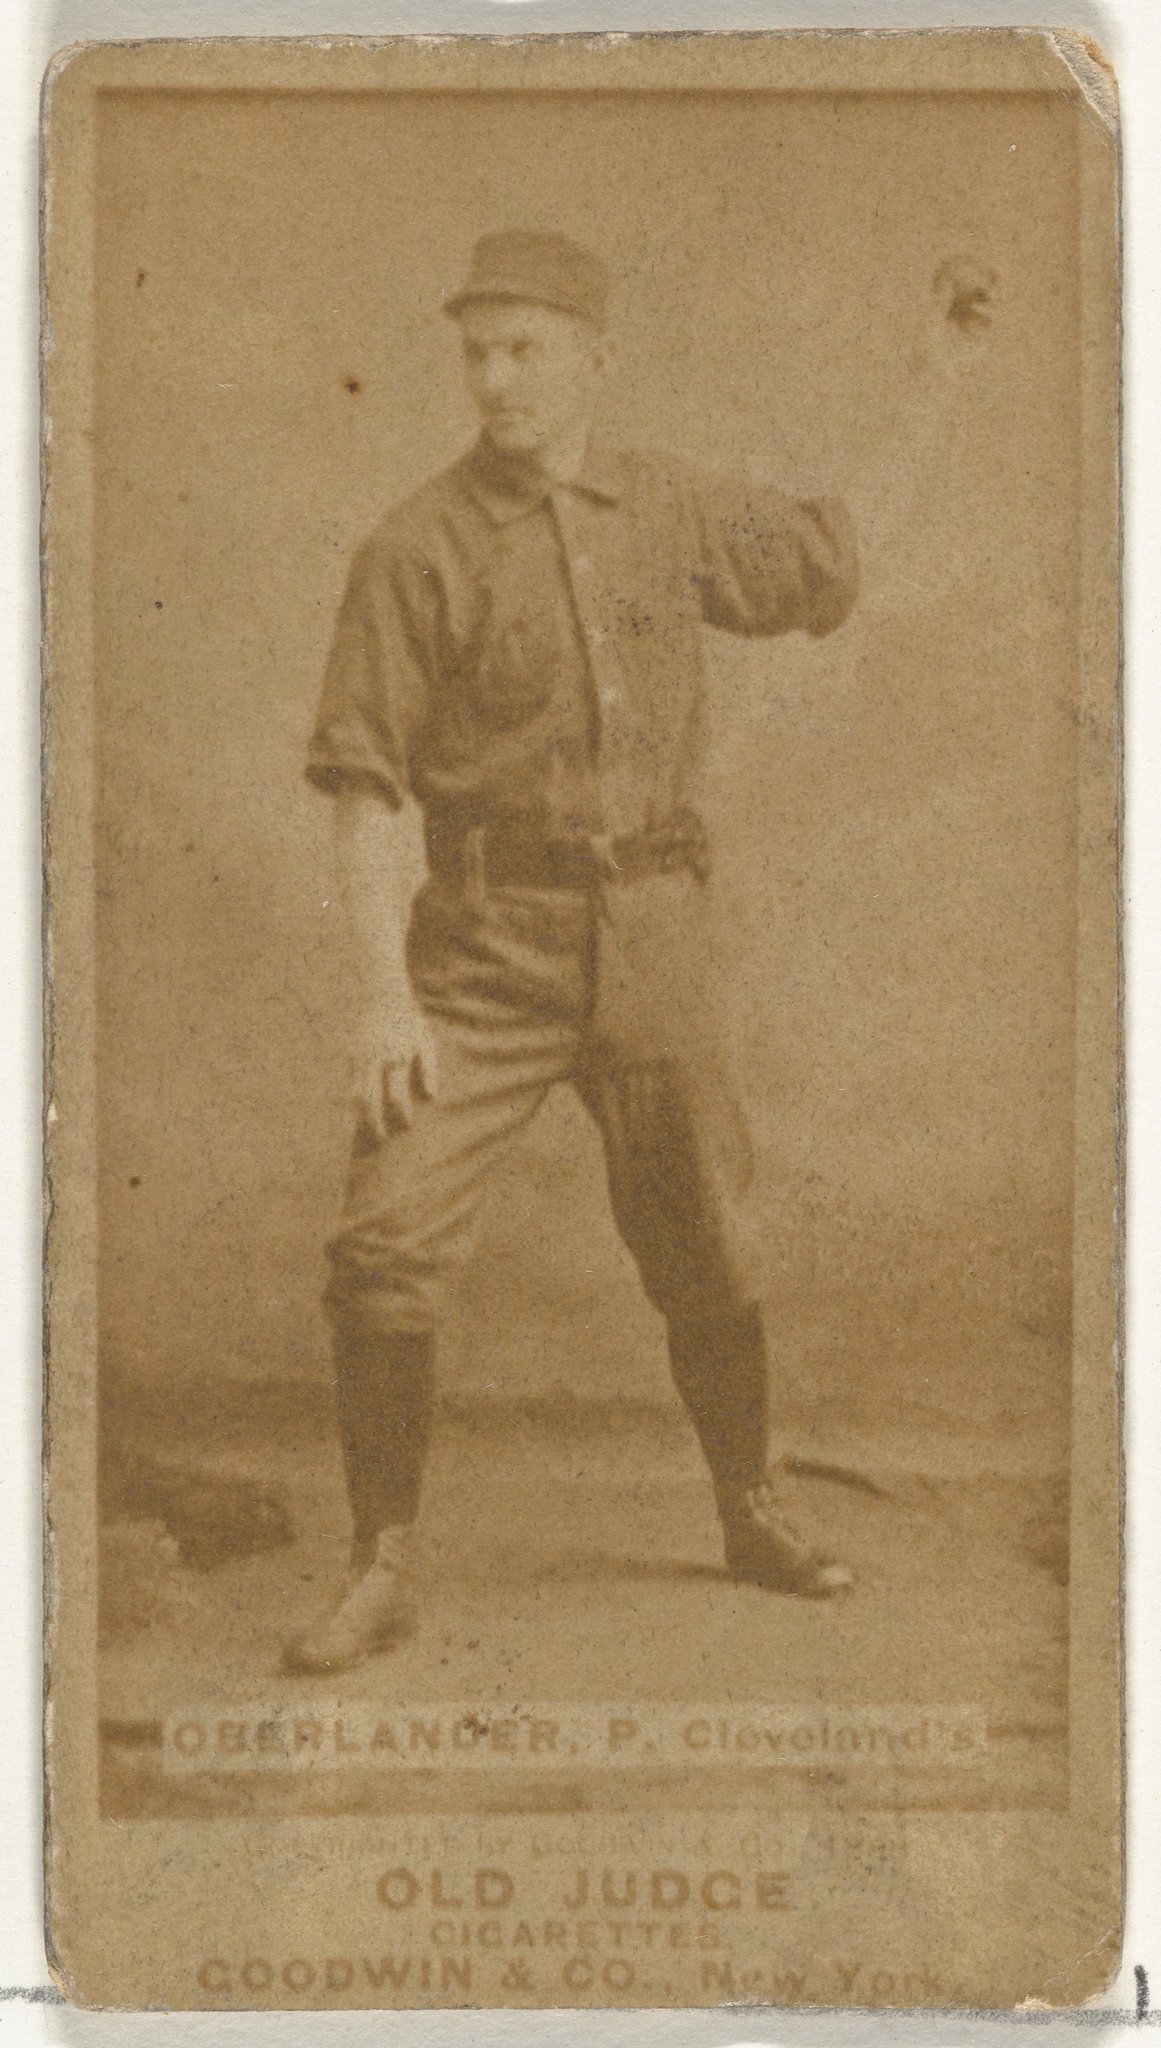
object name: baseball card, photograph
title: Hartman Louis "Doc" Oberlander, Pitcher, Cleveland, from the Old Judge series (N172) for Old Judge Cigarettes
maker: goodwin & company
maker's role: publisher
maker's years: 1850-1950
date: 1887-1890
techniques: albumen silver print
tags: men,portraits,baseball,athletes